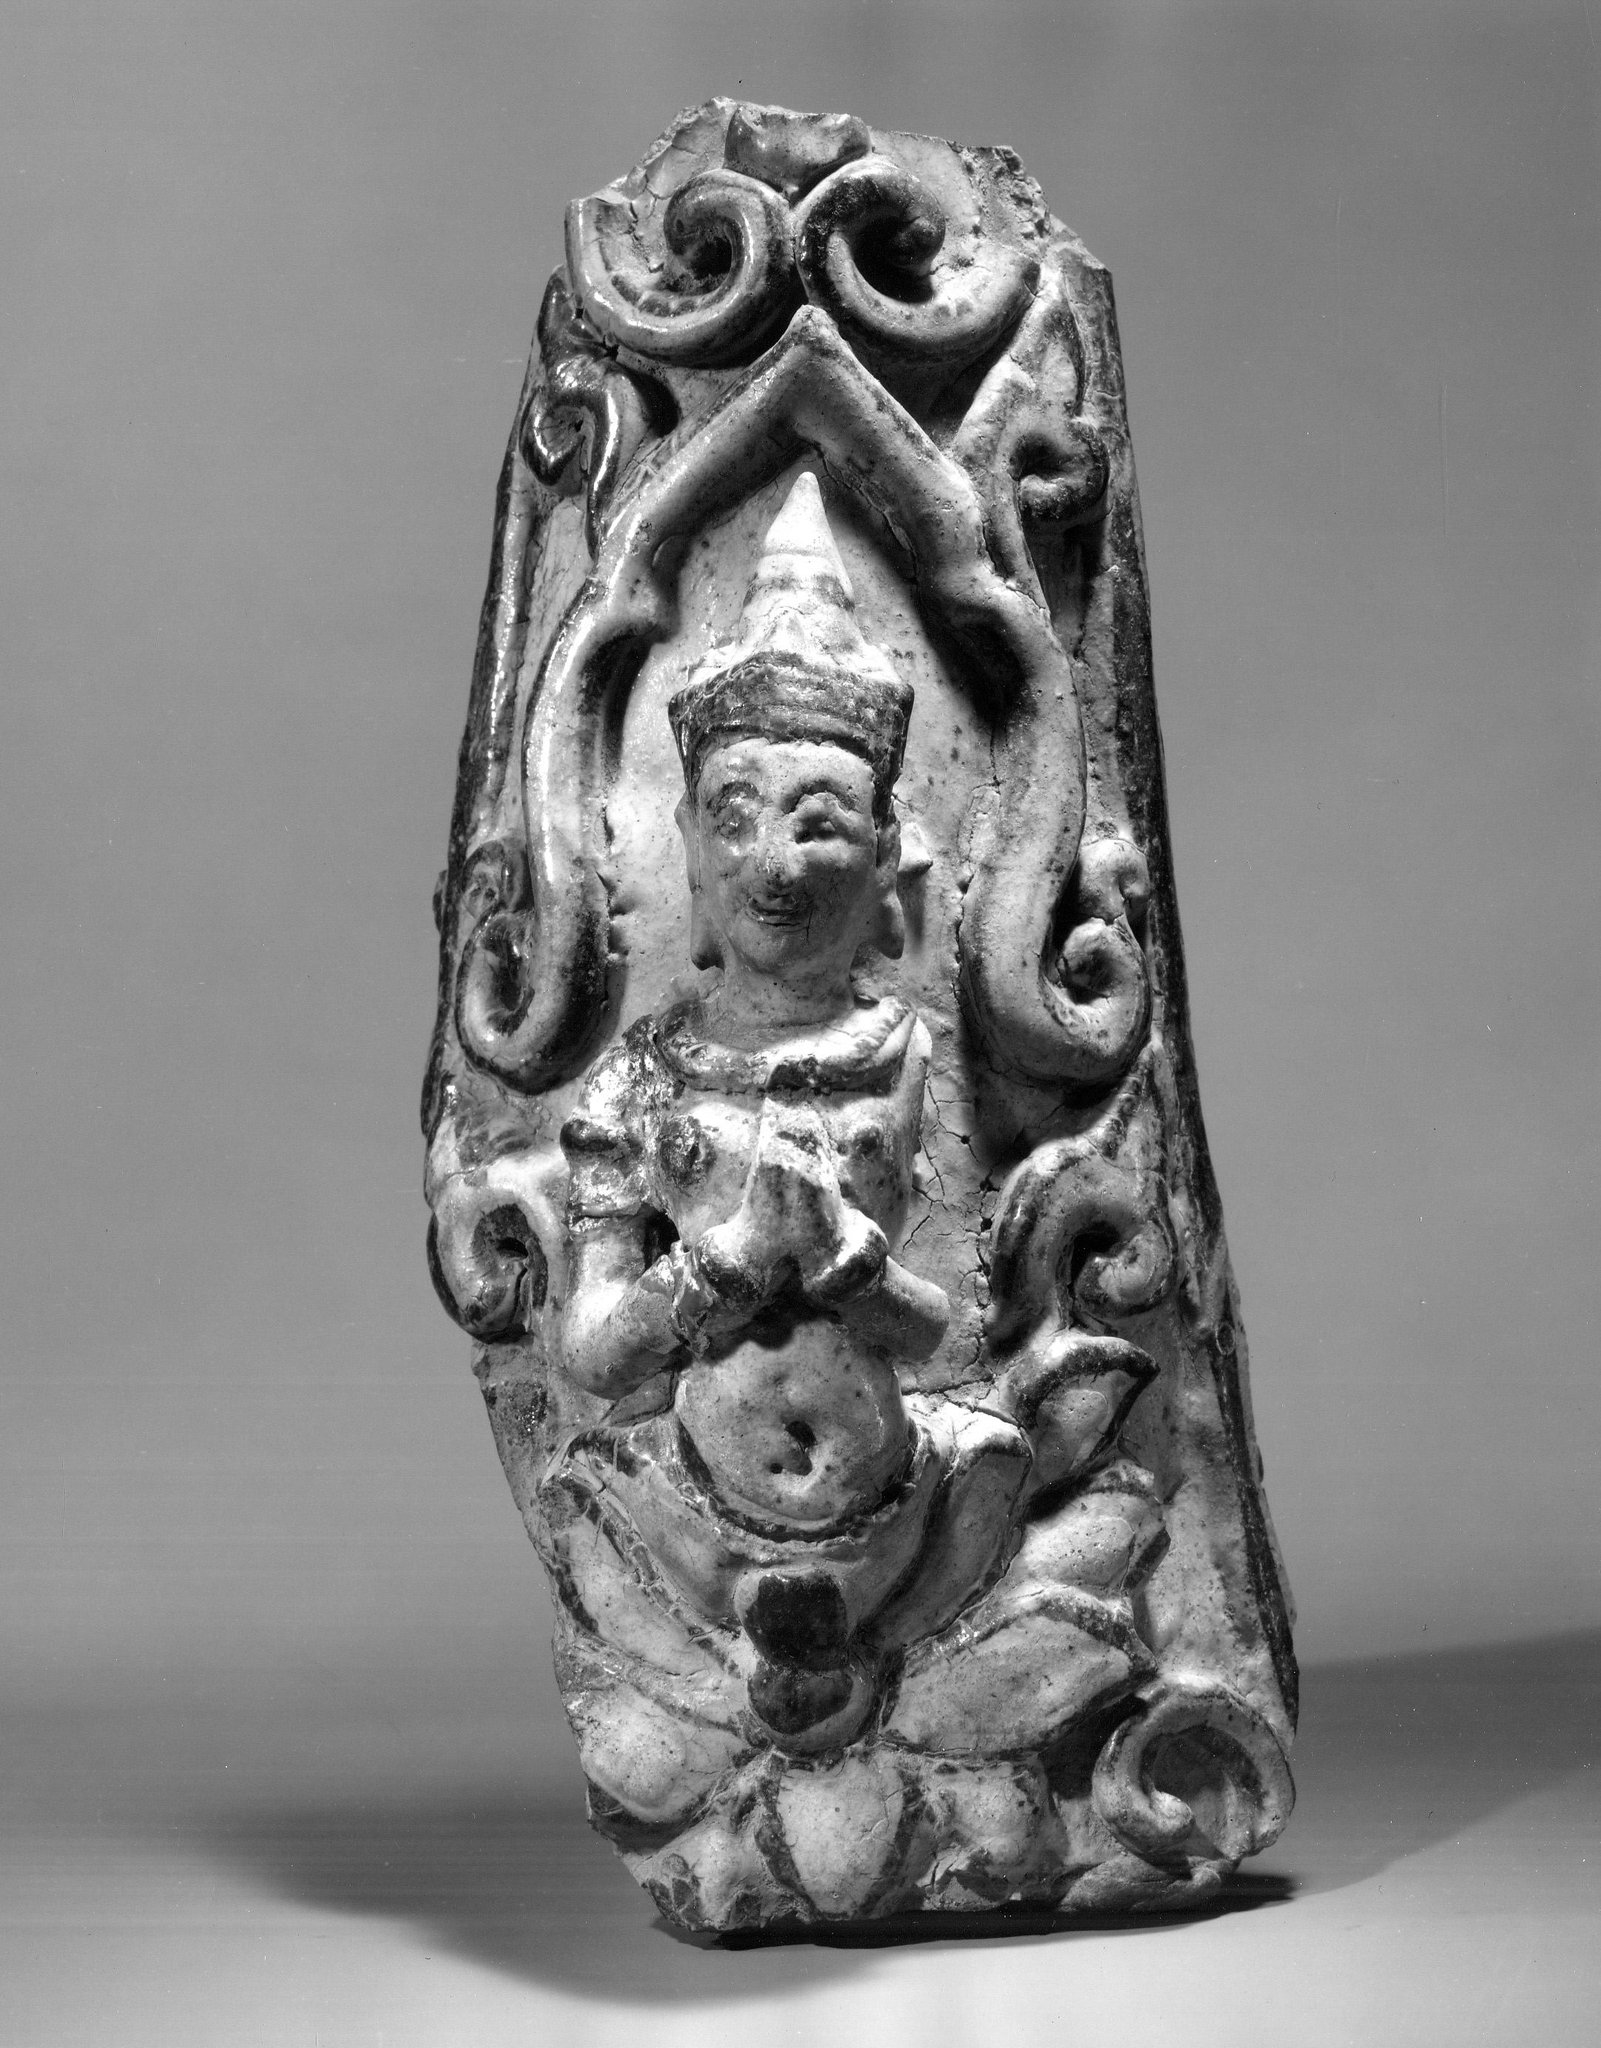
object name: architectural tile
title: Architectural Tile with Apsara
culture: thailand, sukhothai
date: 1301-1500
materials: ceramic, gilt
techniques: glazing